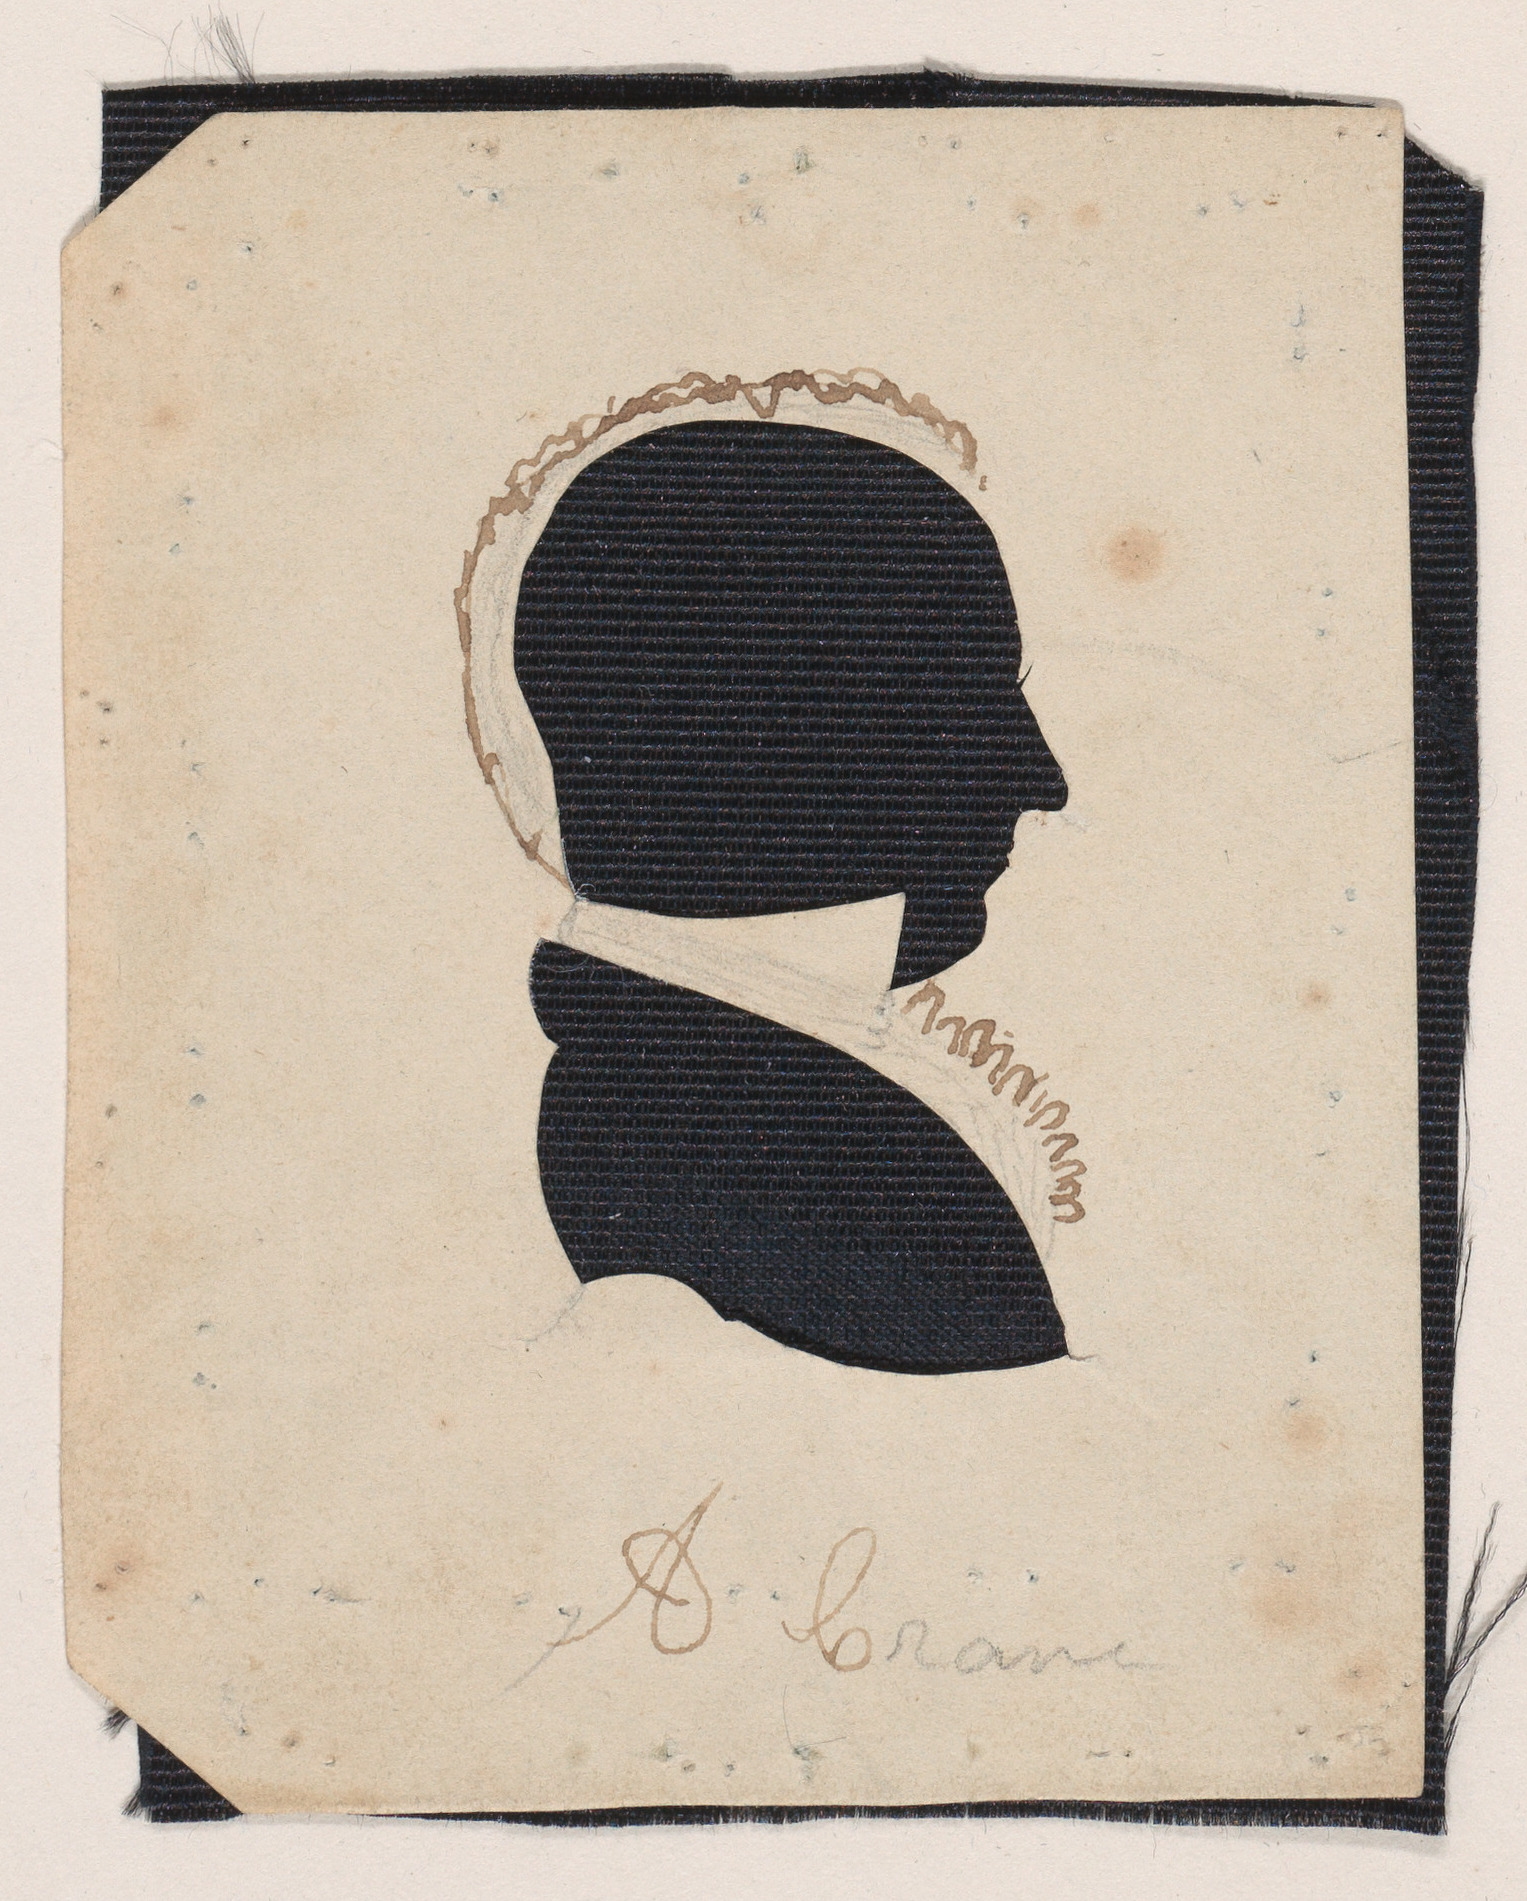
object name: cut paper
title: Silhouette of Aaron Crane, to right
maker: william chamberlain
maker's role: artist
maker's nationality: american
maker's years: 1790-1890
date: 1824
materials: paper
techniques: cutting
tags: men